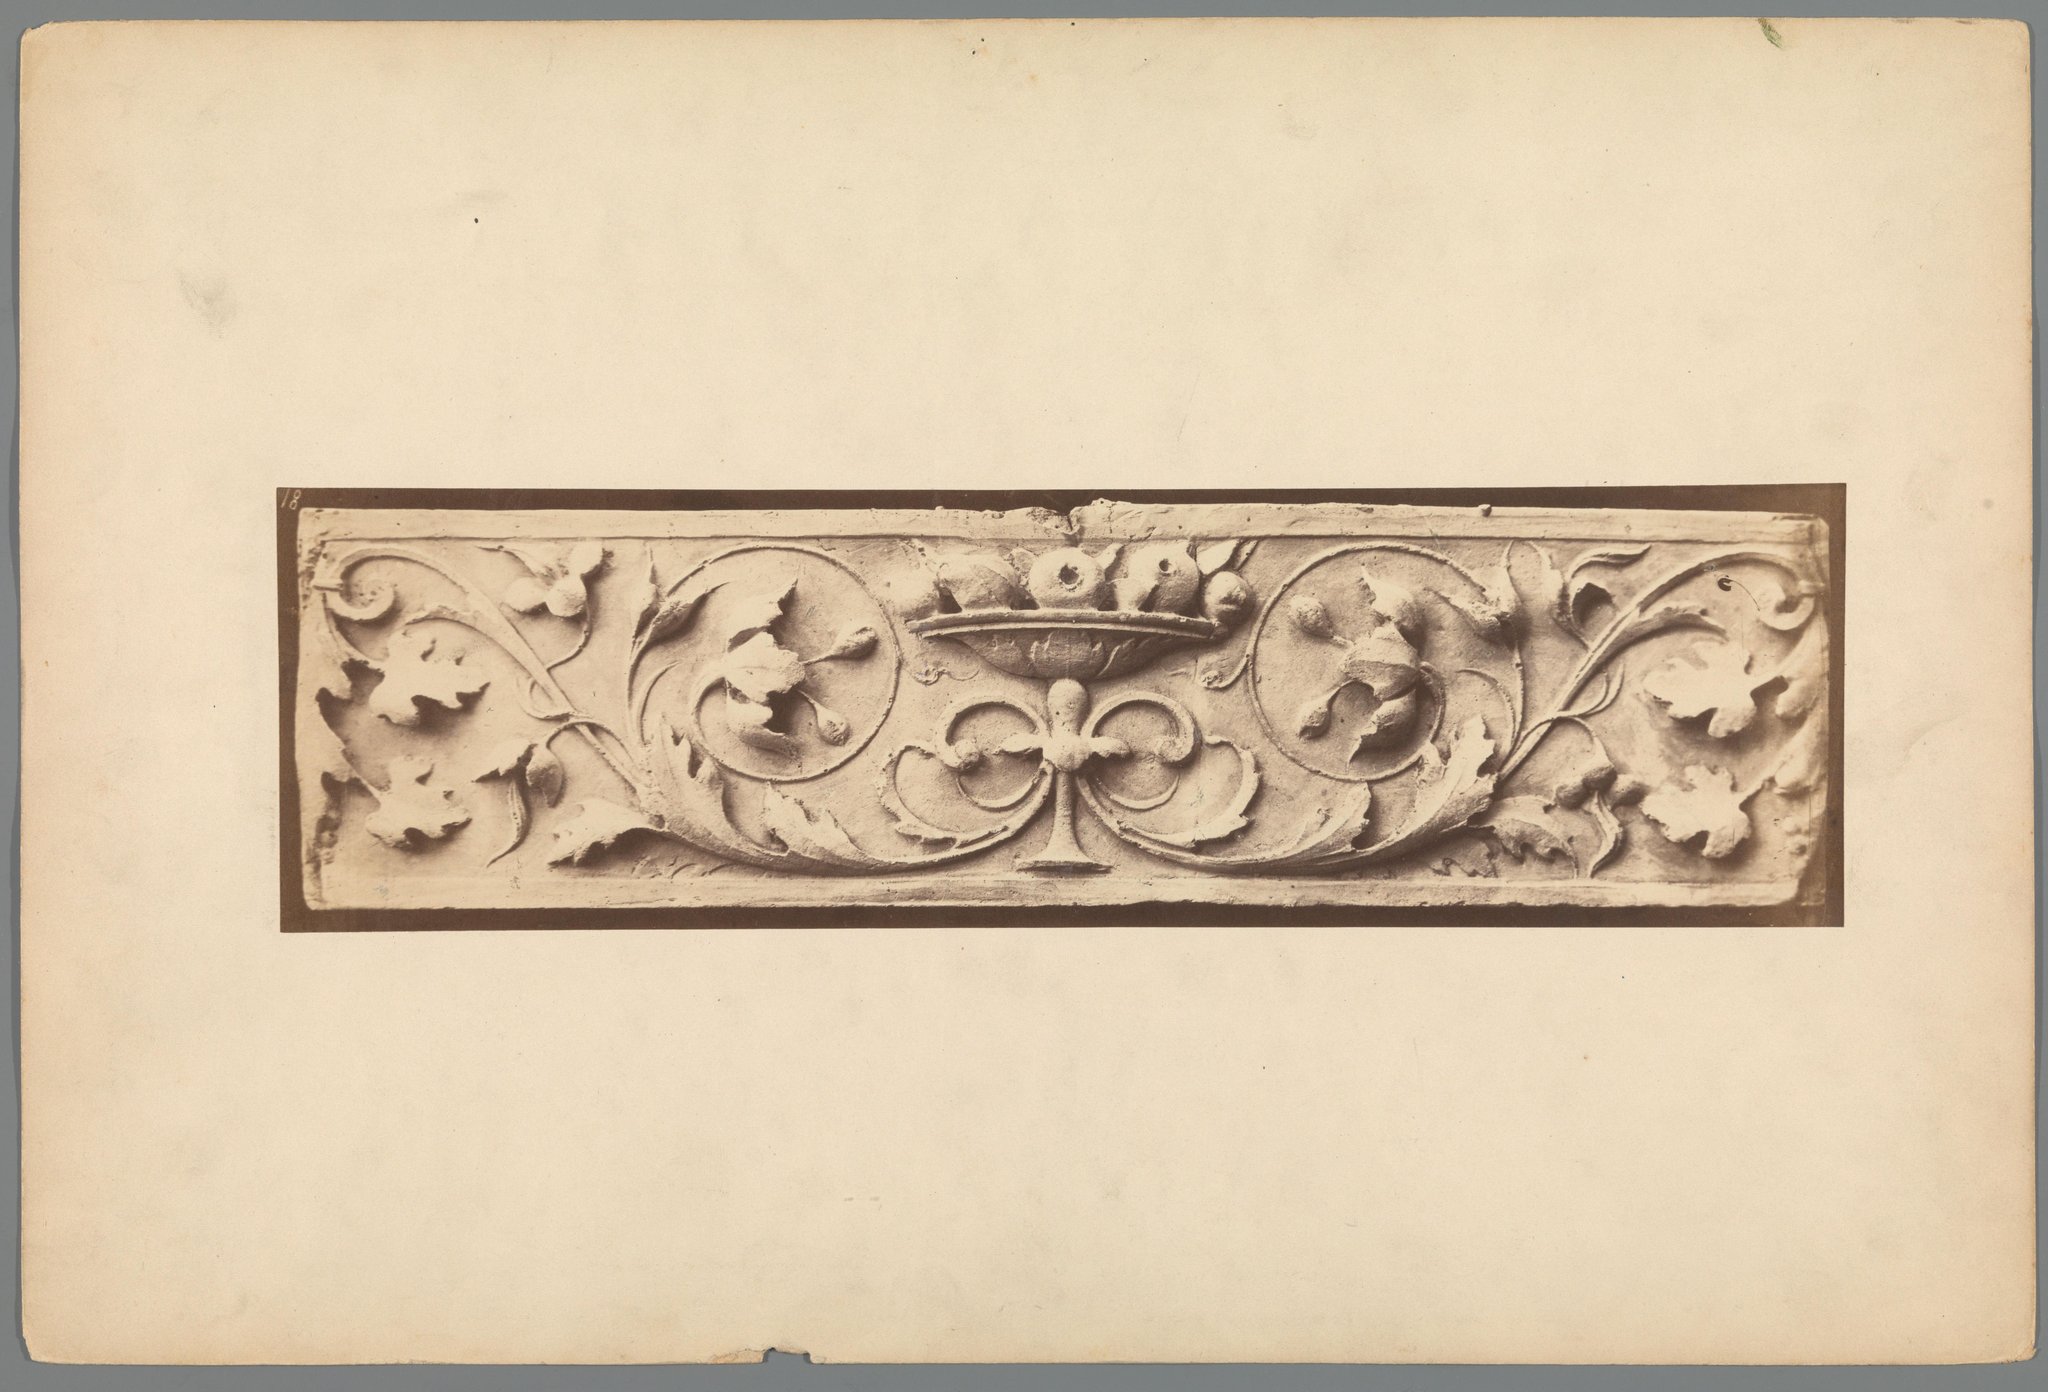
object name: photograph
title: Reliëf met bladmotieven en een schaal met fruit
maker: Anonymous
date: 1875-1900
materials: cardboard, photographic support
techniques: albumen print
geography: europe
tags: fruits and vegetables ~ ornament, dish, plate, saucer, ornament derived from plant forms, sculpture (+ relief ~ sculpture), europe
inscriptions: number: ‘18’, collector's mark: Lugt 3937